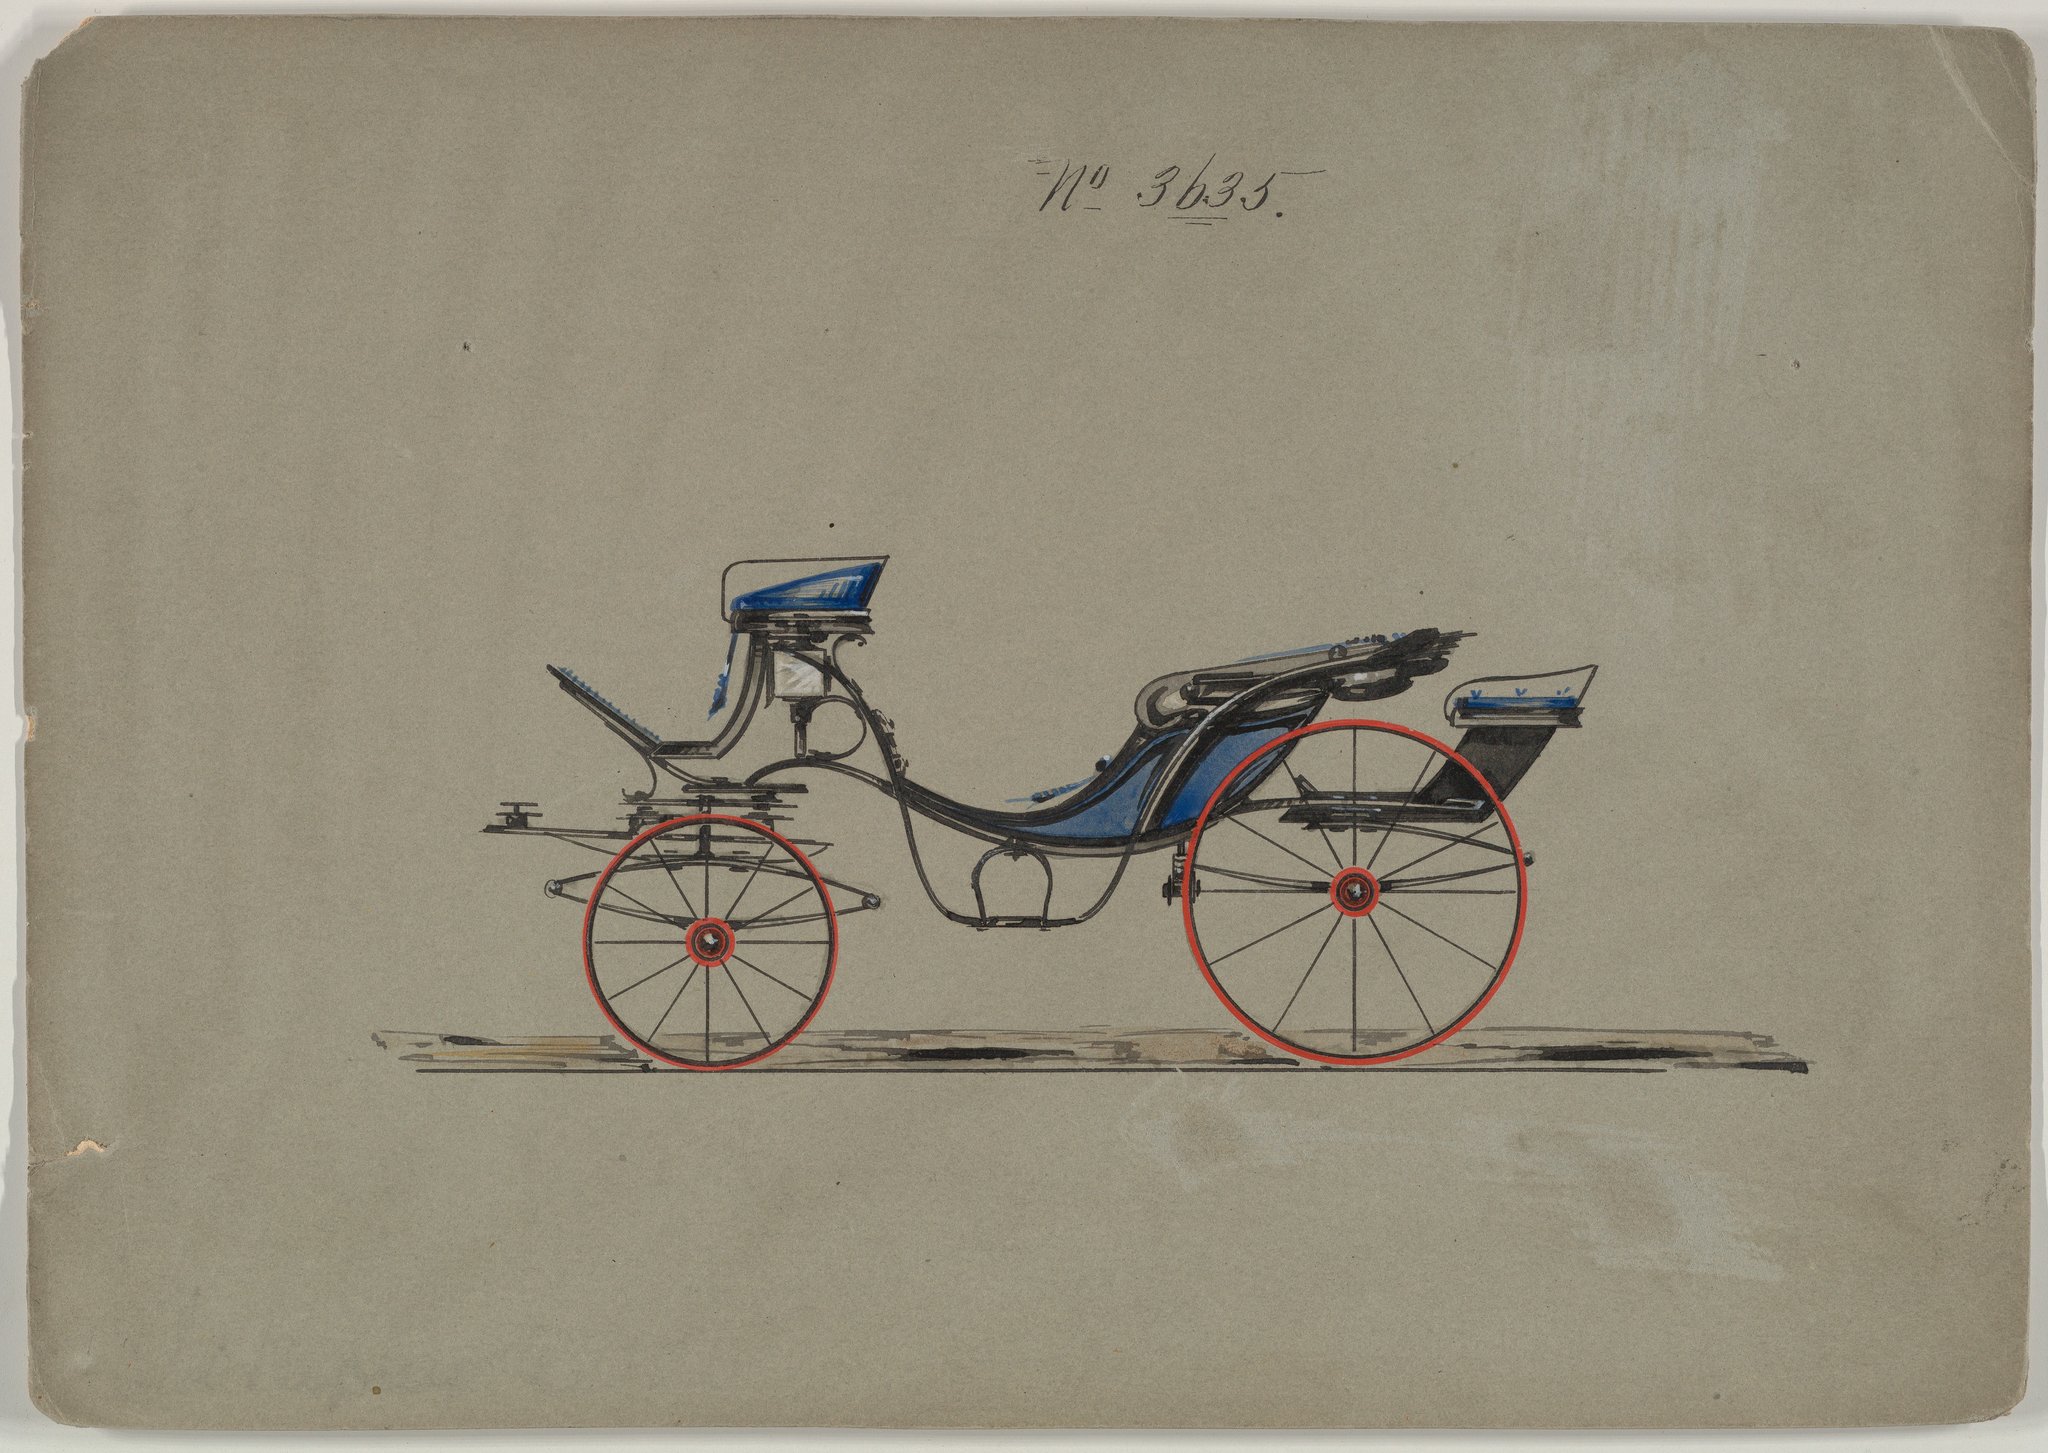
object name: drawing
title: Design for Cabriolet or Victoria, no. 3635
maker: brewster & co.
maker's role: manufacturer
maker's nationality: american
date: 1880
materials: gouache, gum arabic, ink, watercolor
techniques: pen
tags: carriages